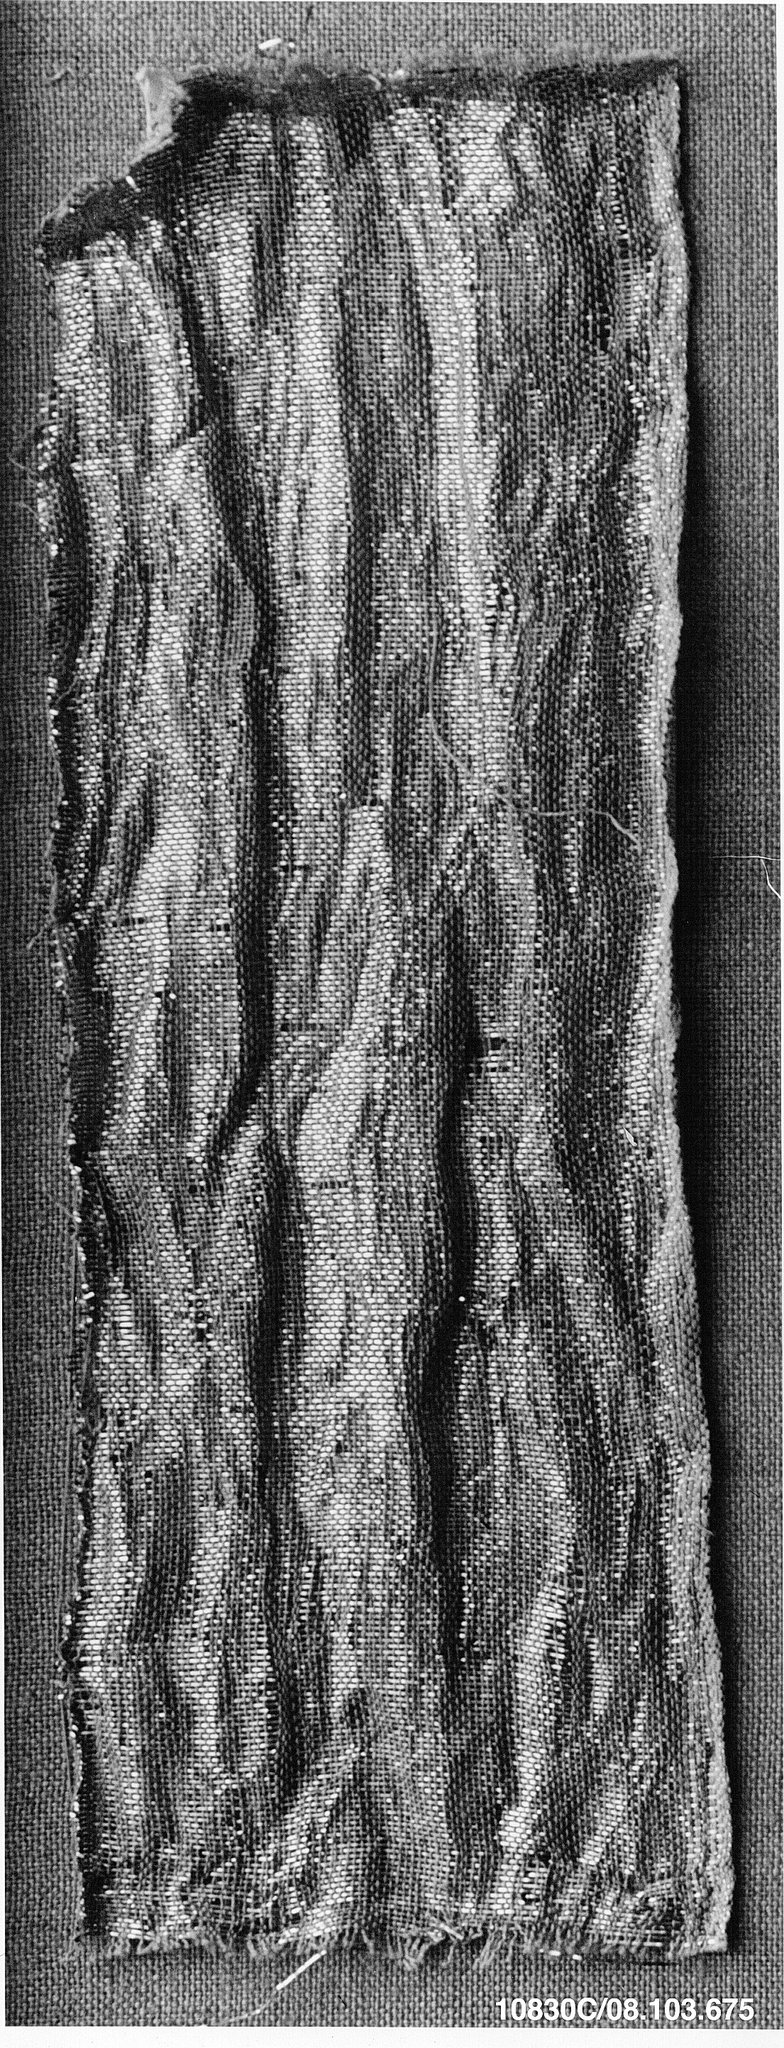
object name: piece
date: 1801-1833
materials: thread